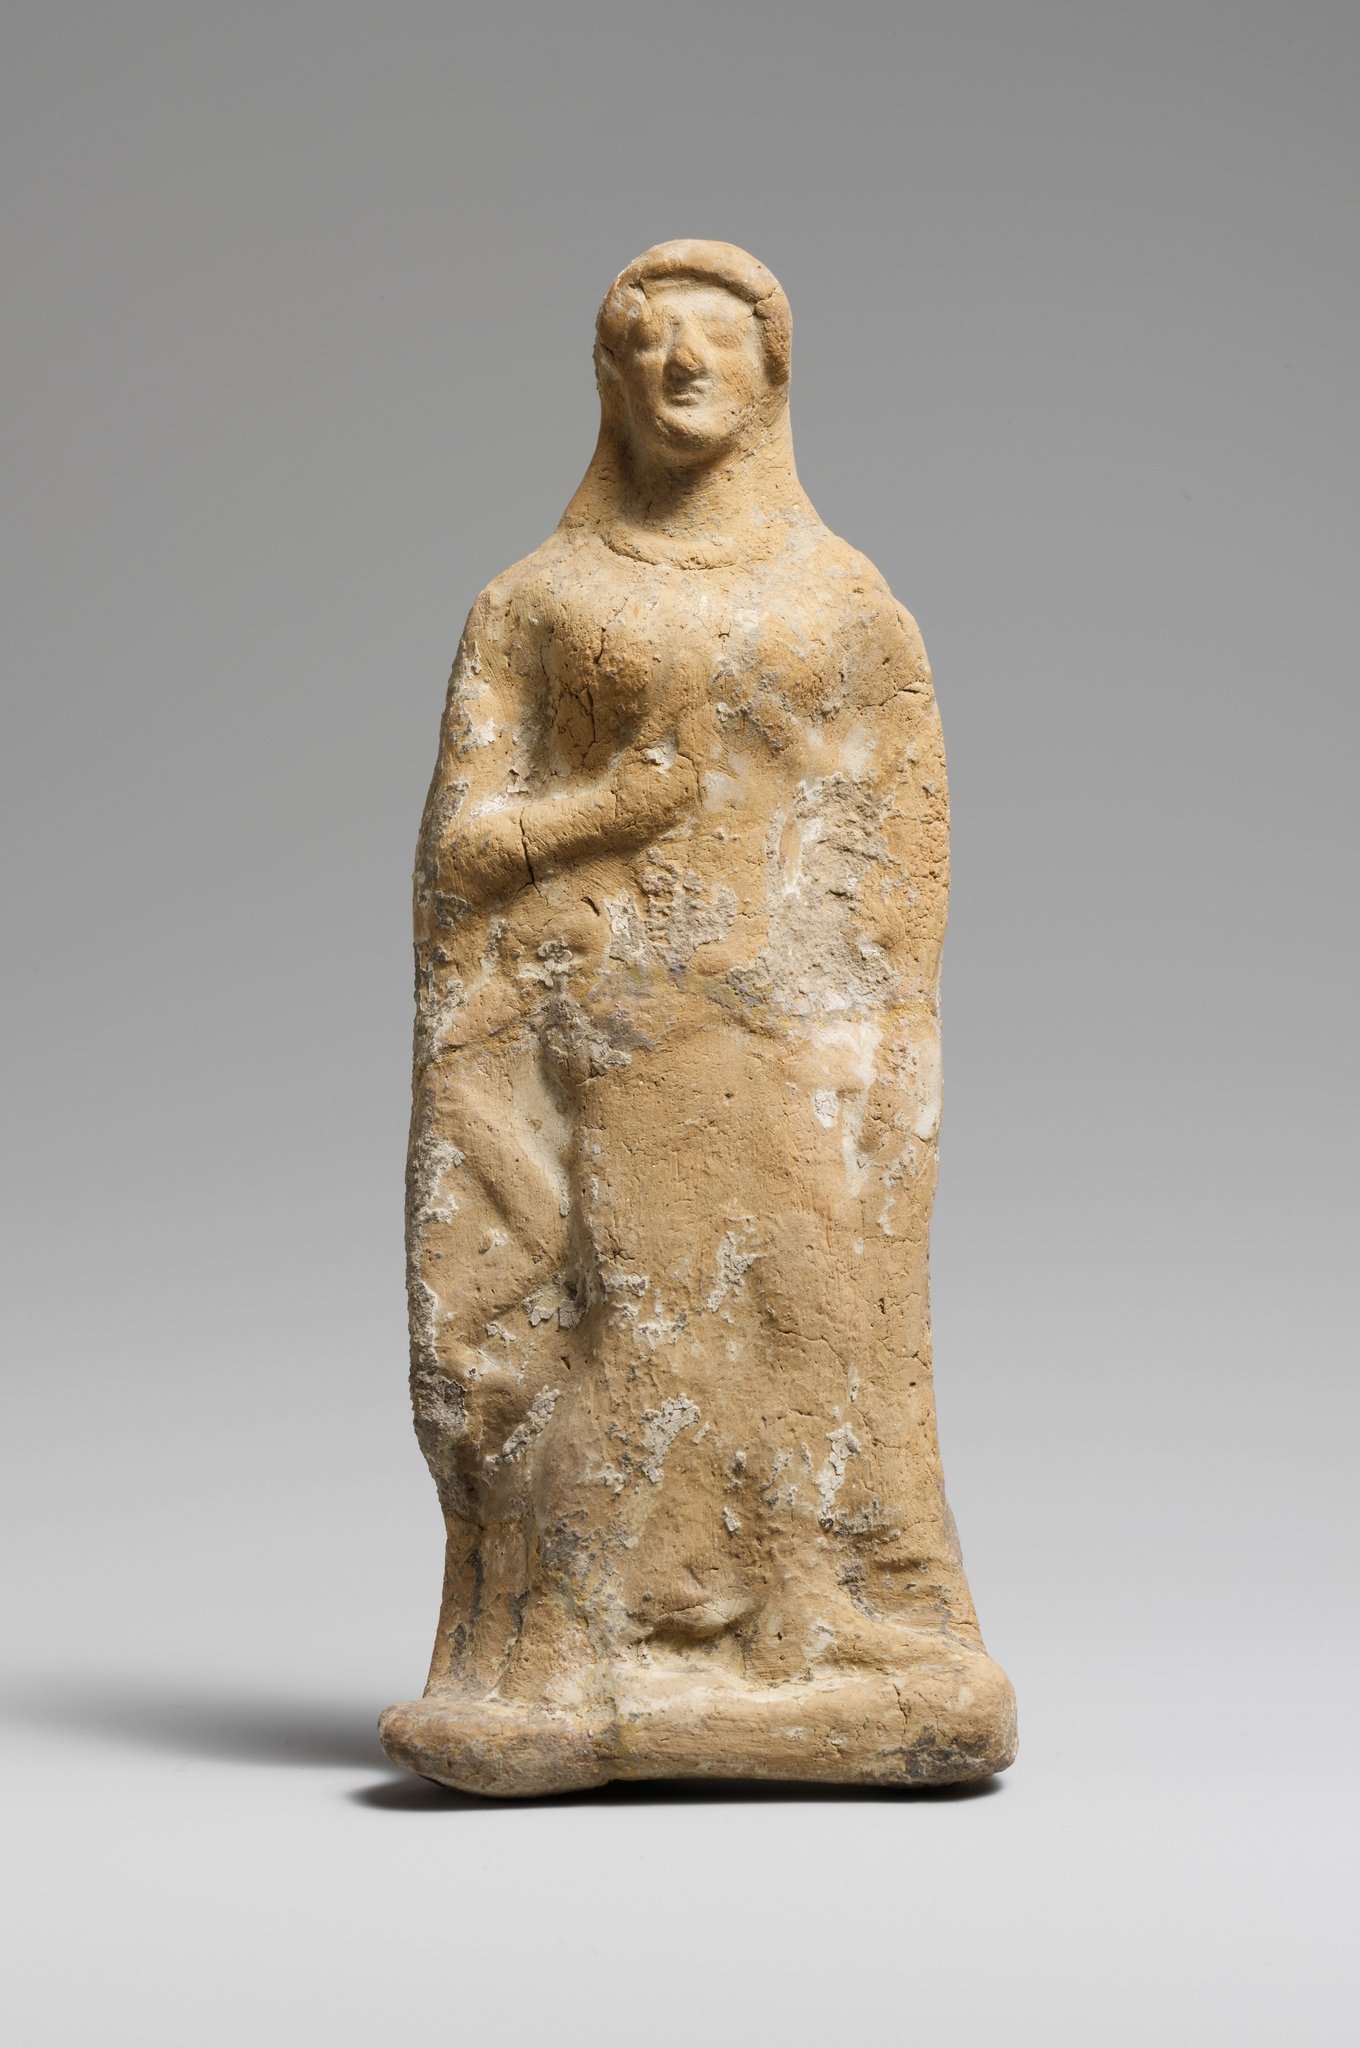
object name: statuette of a woman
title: Terracotta statuette of a woman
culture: greek, attic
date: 467-435 BCE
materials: terracotta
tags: women